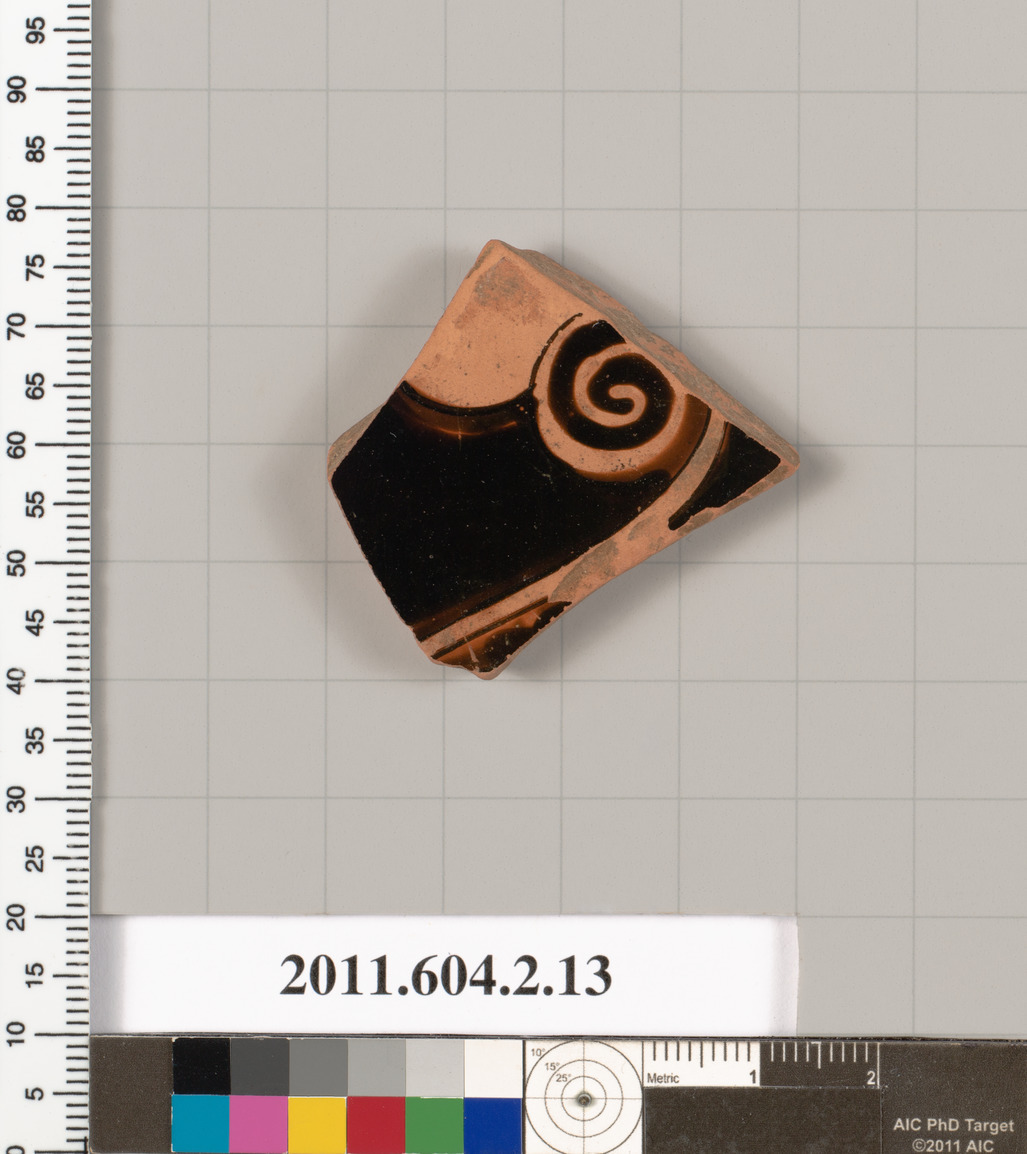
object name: neck amphora fragment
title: Terracotta fragment of a neck-amphora (jar)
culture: greek, attic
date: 475-451 BCE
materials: terracotta